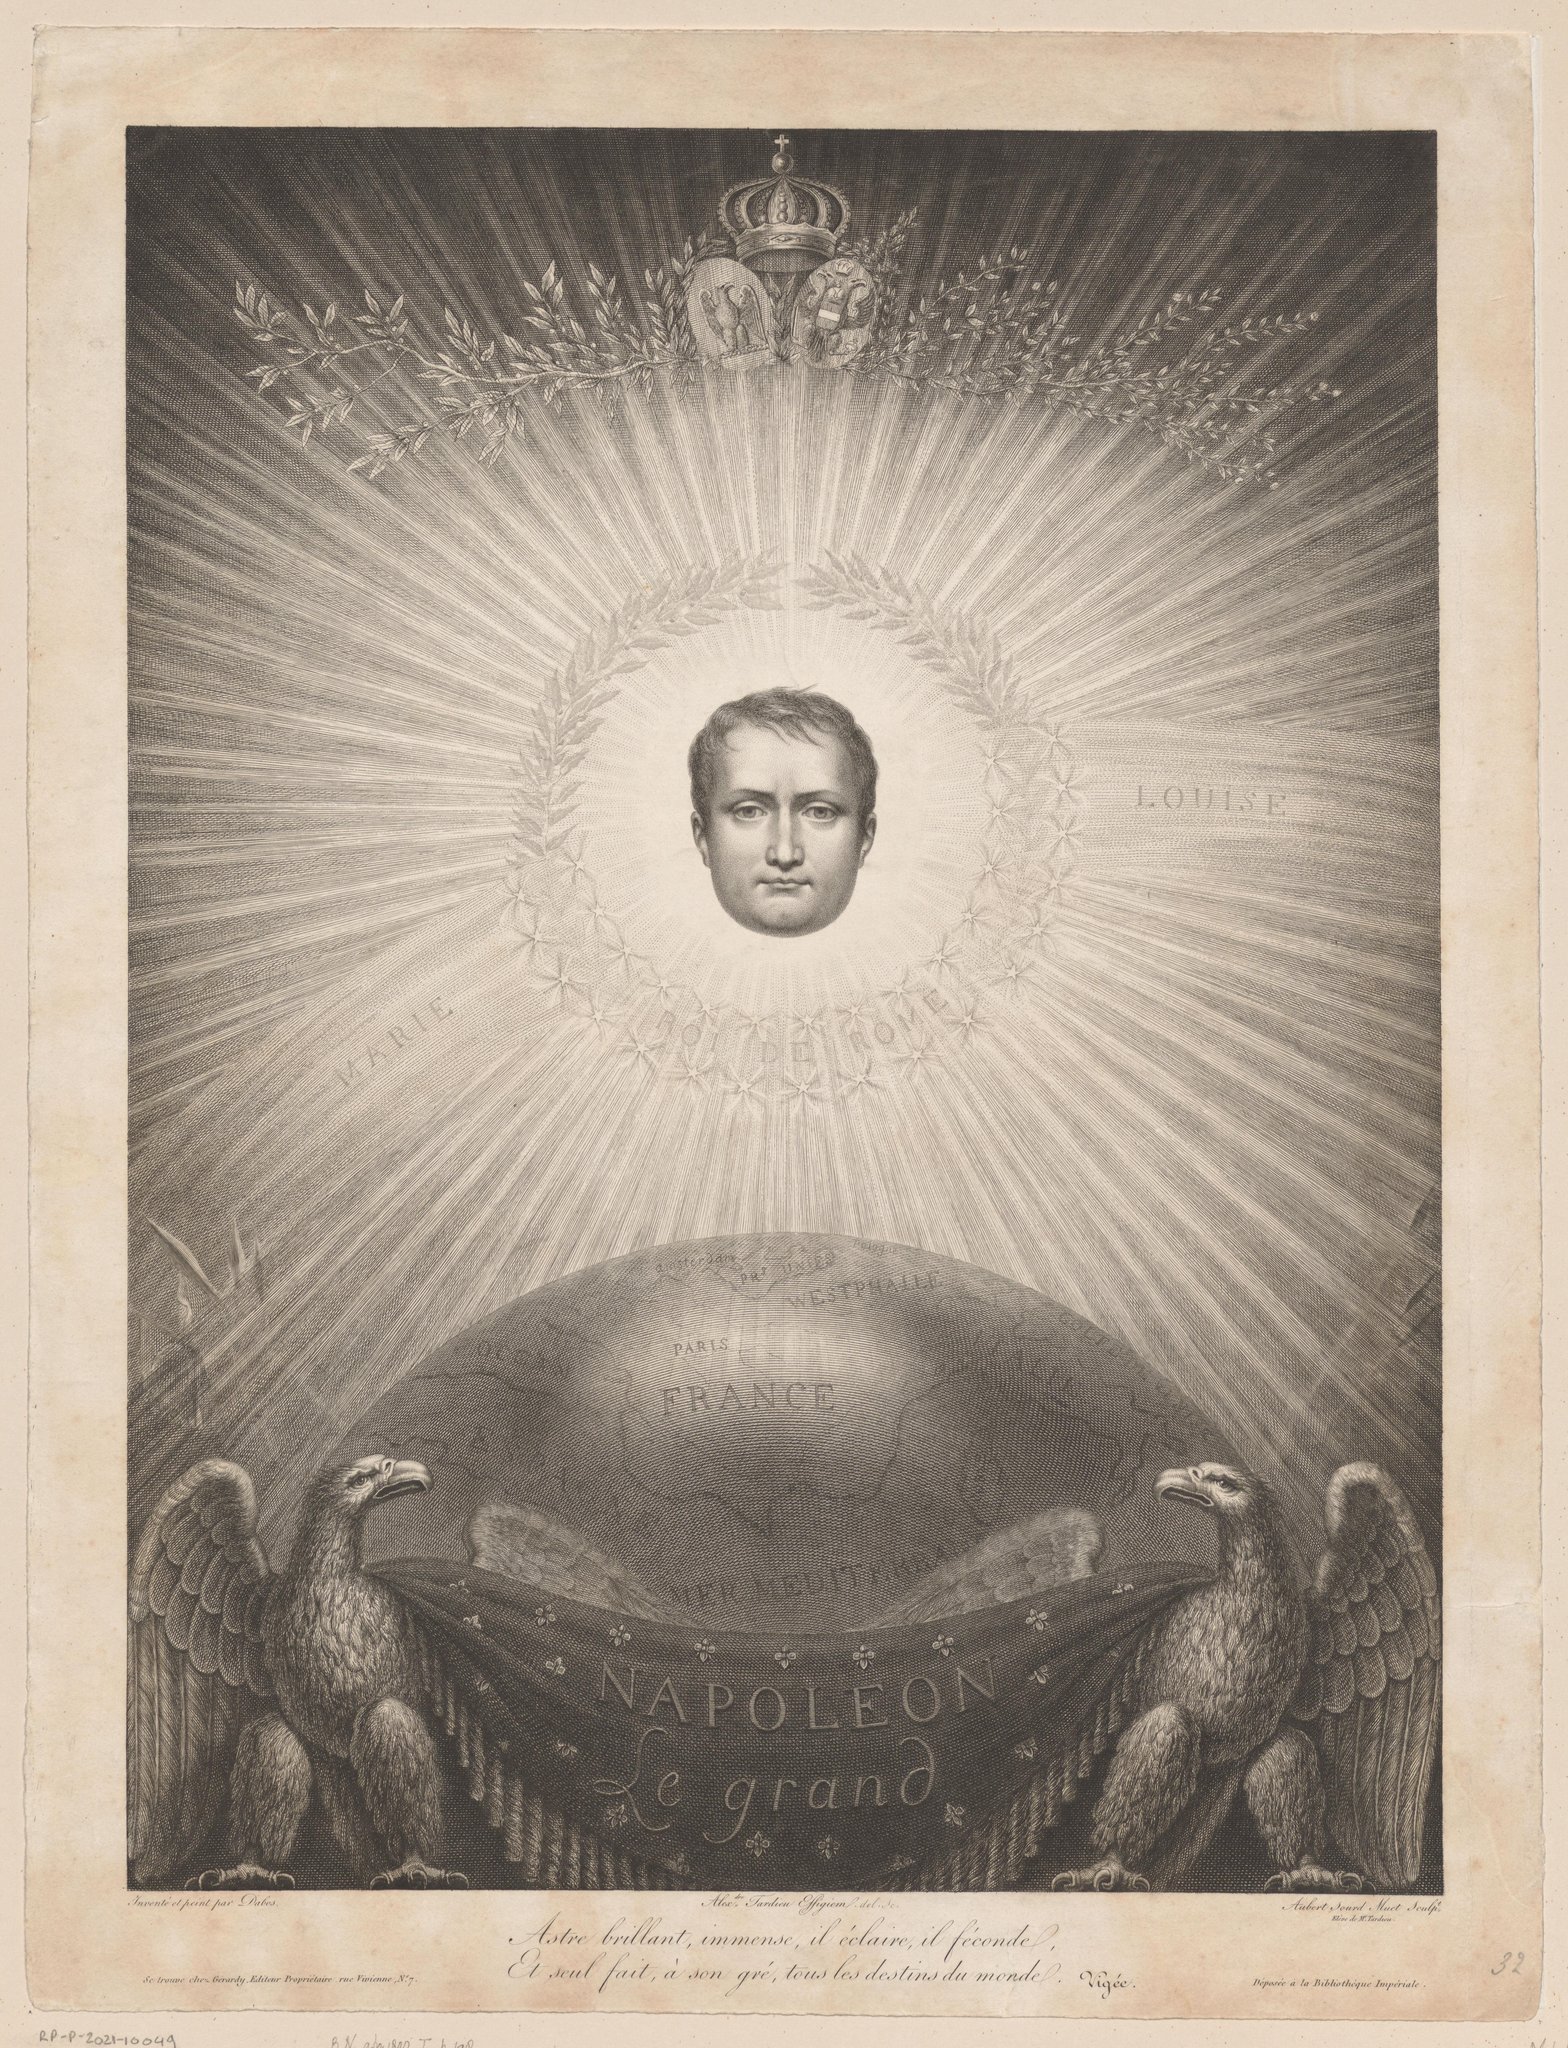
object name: print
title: Verheerlijking van Napoleon Bonaparte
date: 1810-1815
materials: paper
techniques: engraving, etching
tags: napoleon i (emperor of the french), deaf and non-verbal, formerly known as 'deaf-mute', predatory birds: eagle, historical persons, emperor, globe, armorial bearing, heraldry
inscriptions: : ‘Déposé à la Bibliothèque Impériale’, inscription: ‘No. 523’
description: Hoofd van Napoleon in een lauwerkrans boven een wereldbol.